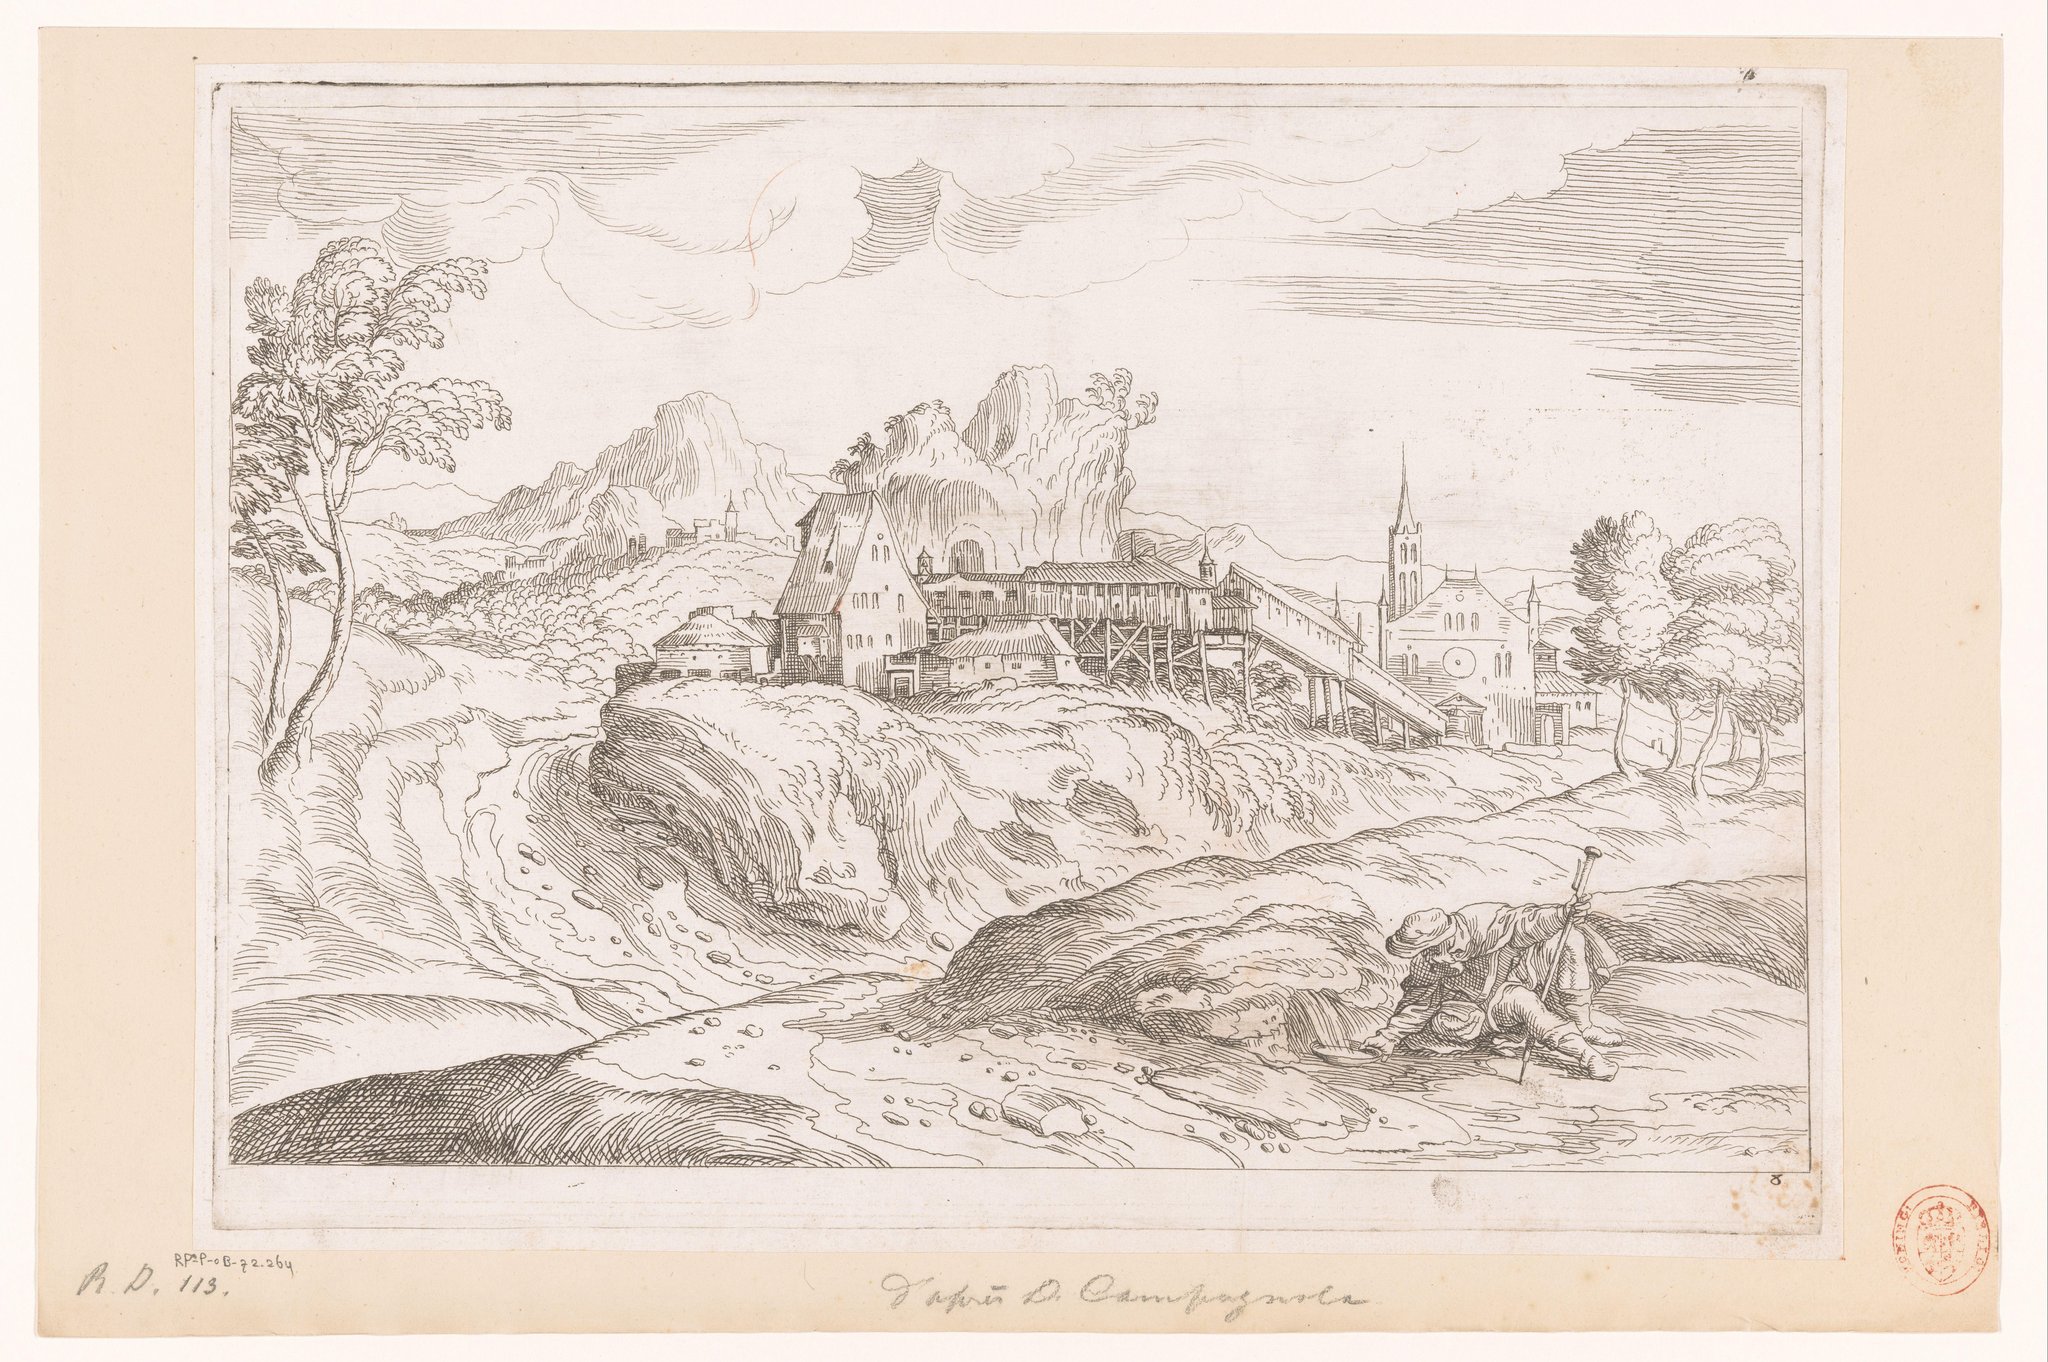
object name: print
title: Landschap met rustende pelgrim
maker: jean pesne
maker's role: print maker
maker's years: 1623-1700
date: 1666-1695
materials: paper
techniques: etching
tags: pilgrim(s), church (exterior), outskirts of village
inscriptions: collector's mark: Lugt 240, number: ‘8’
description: Prent maakt deel uit van een serie van 283 prenten, ongenummerde staat.